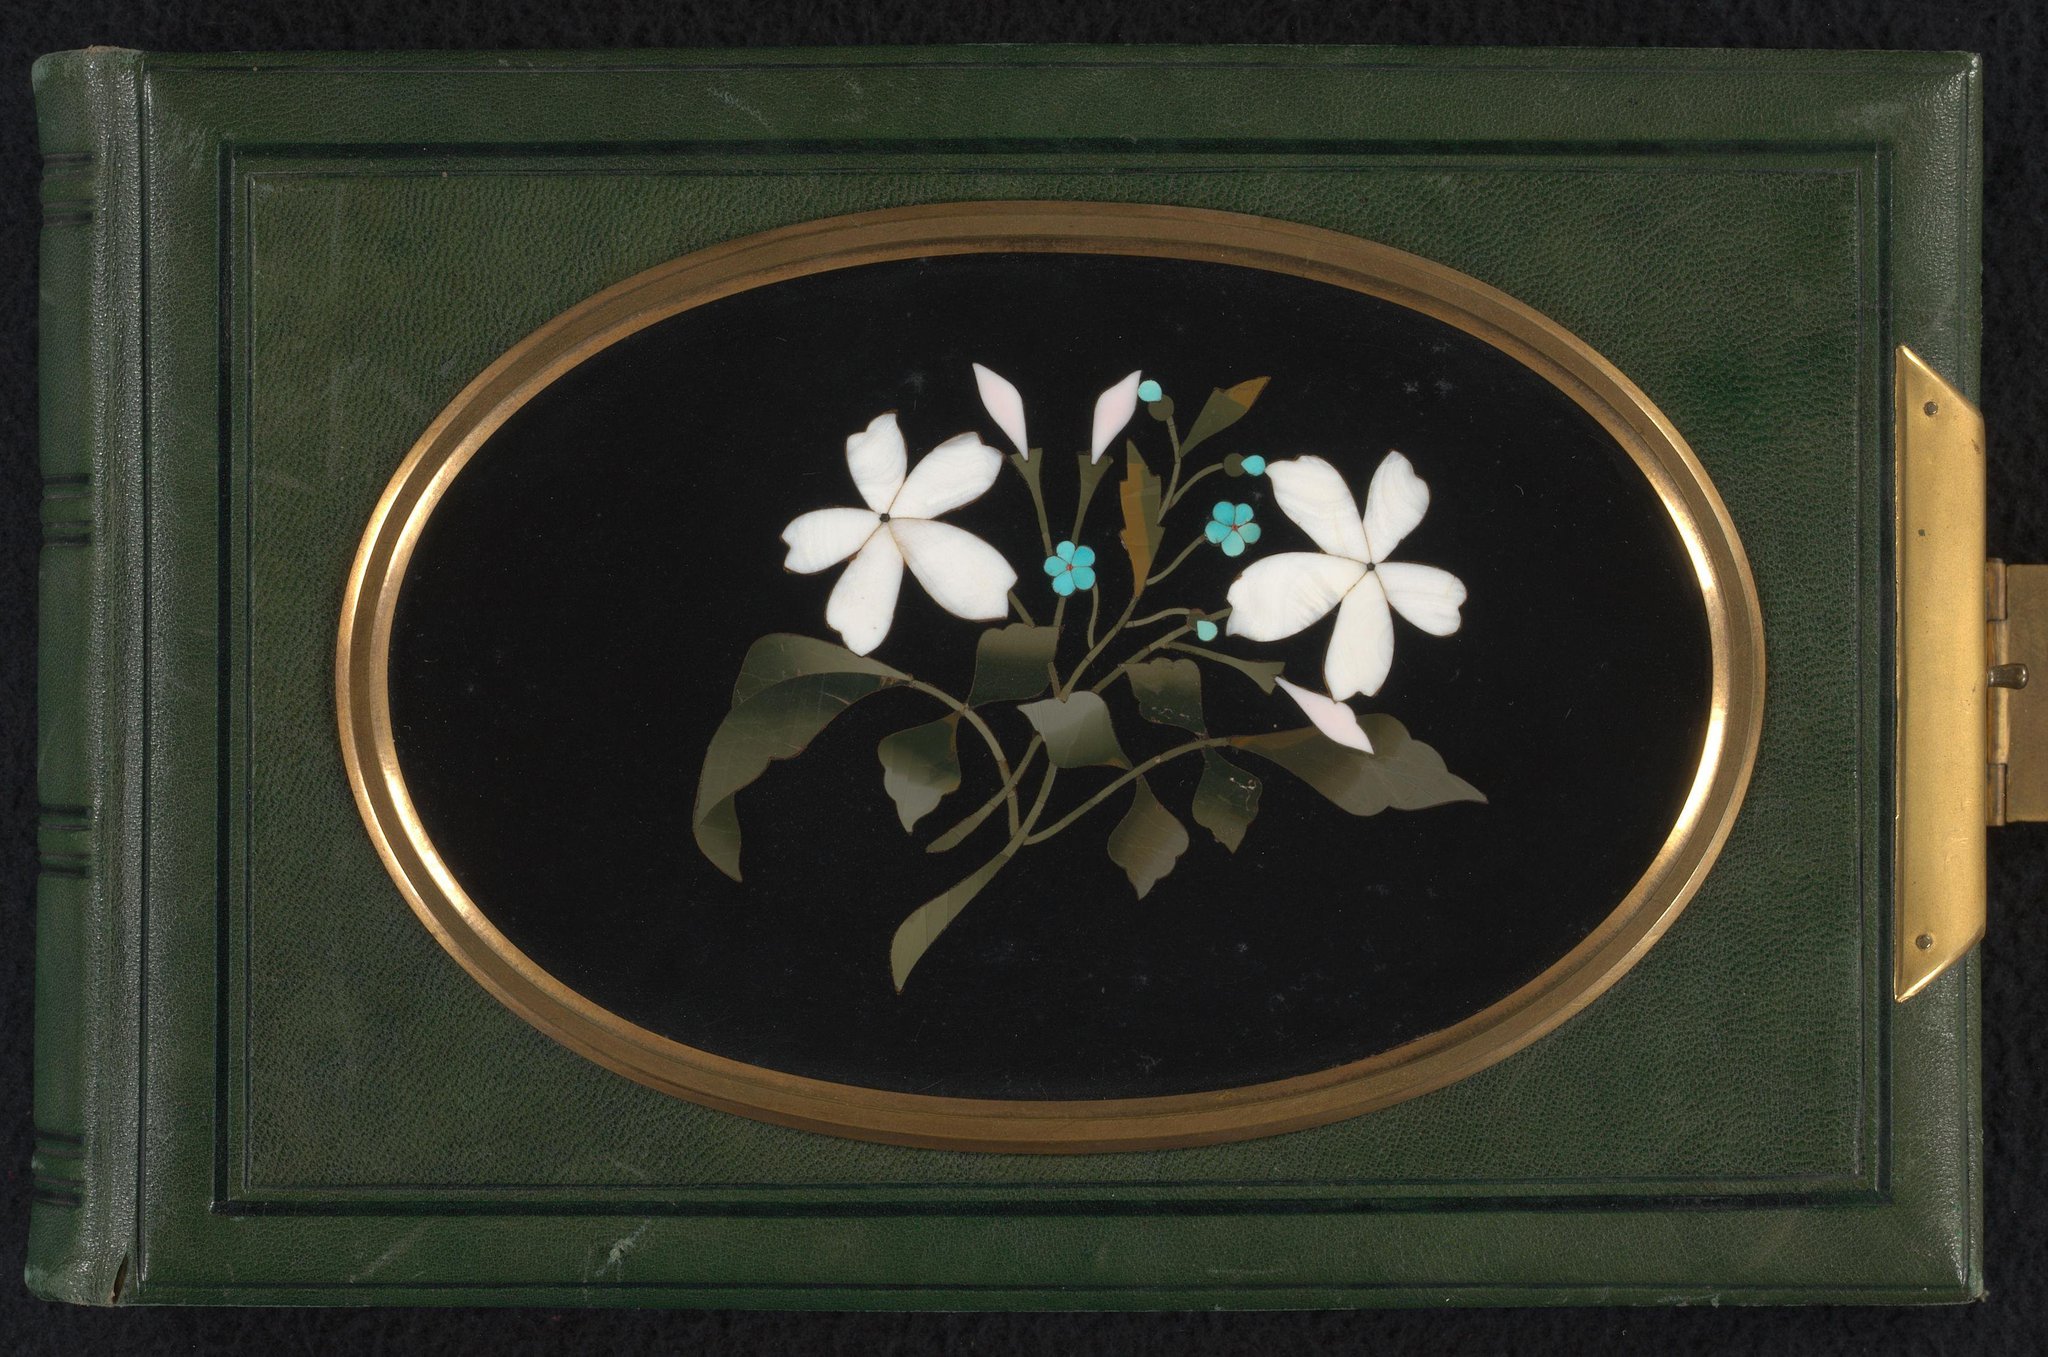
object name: slip in album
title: Nederlands familiealbum met 48 foto's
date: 1860-1900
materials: cardboard, leather, metal, paper, photographic support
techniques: albumen print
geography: netherlands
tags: historical persons - bb - woman, child, historical persons, (playing with) toys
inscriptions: collector's mark: ‘DIENST/ VERSPREIDE/ RIJKSKOLLEKTIES/ (...) A 889’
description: Fotoalbum met 24 bladen met in totaal 48 cartes-de-visite. Ieder blad bevat aan de voorzijde naast elkaar twee met gouden lijnen omkaderde passe-partouts. Afgebeeld zijn portretten van onbekende kinderen. Bij drie foto's is een naam vermeld op verso, vermoedelijk van de geportretteerde. De foto's zijn gemaakt door verschillende Nederlandse fotografen en een Duitse fotograaf, waaronder Albert Greiner, Adolphe Zimmermans en W.G. Kuijer & Zonen. Van 4 foto's is de fotograaf anoniem.